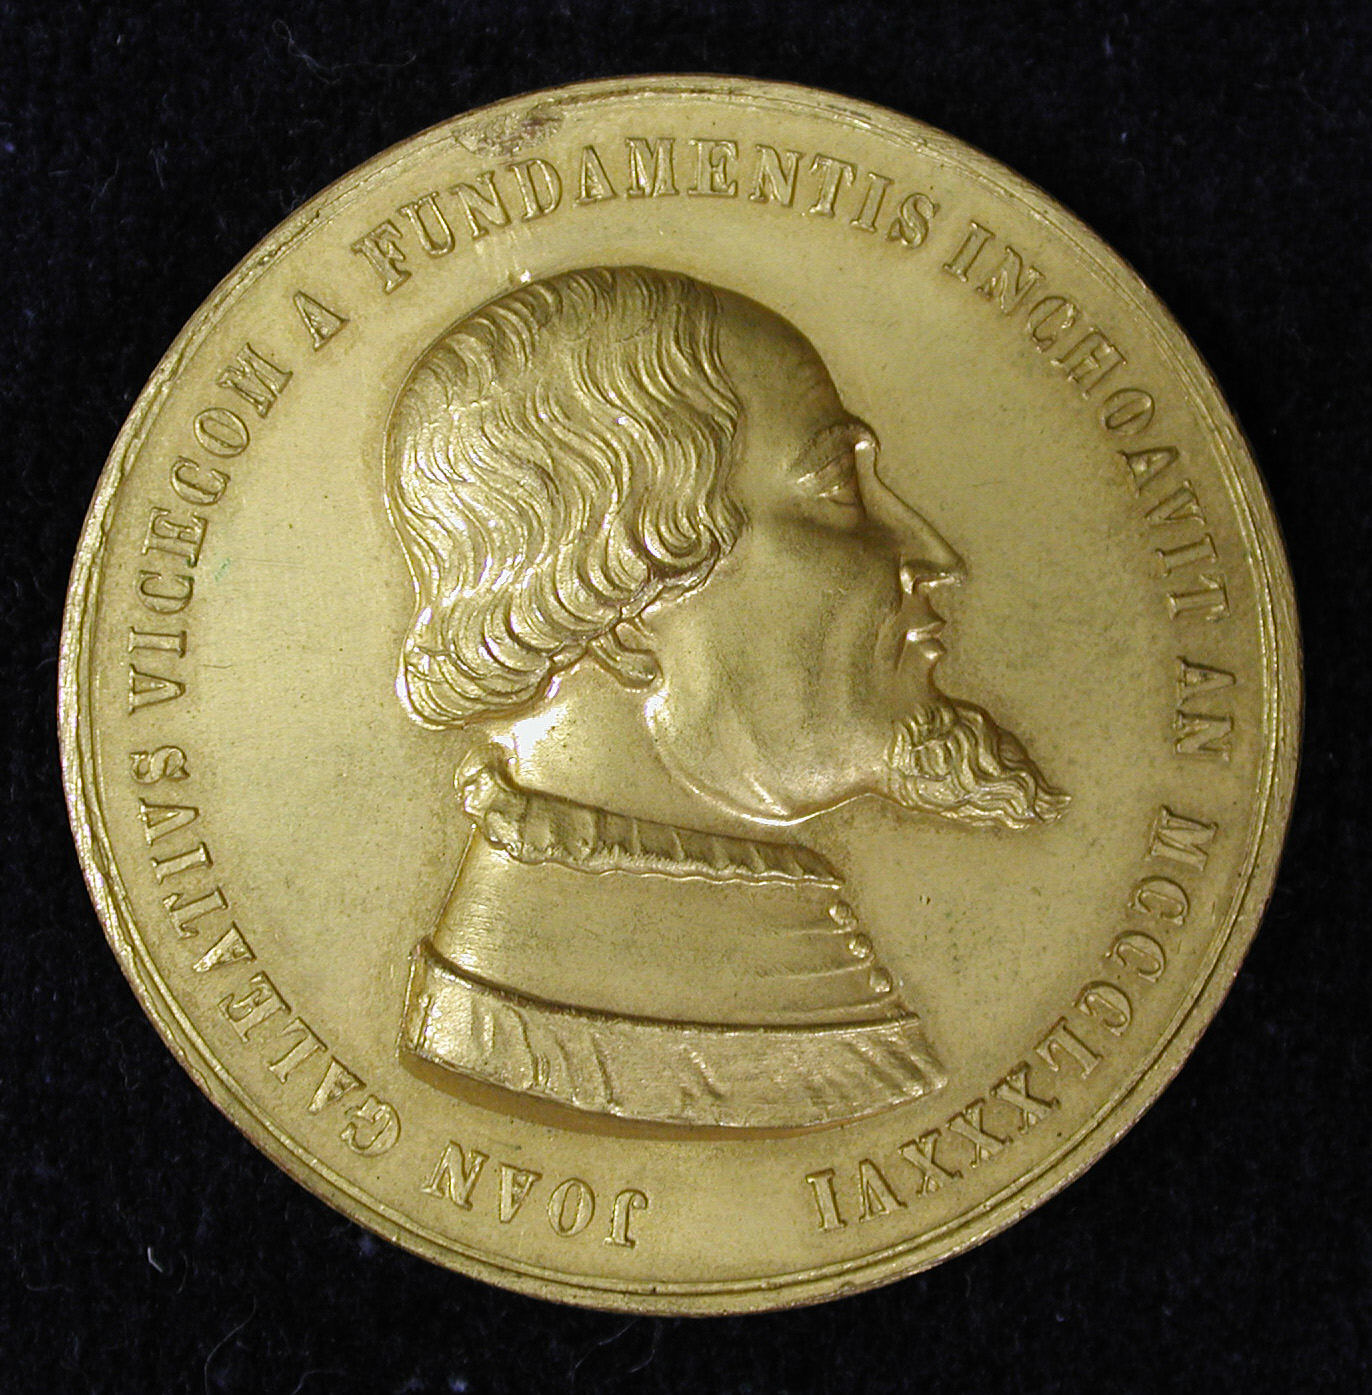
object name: medal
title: Commemorating the Foundation of the Duomo of Milan by Giangaleazzo Visconti in 1386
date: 1701-1900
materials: gilt bronze, gold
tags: men,profiles